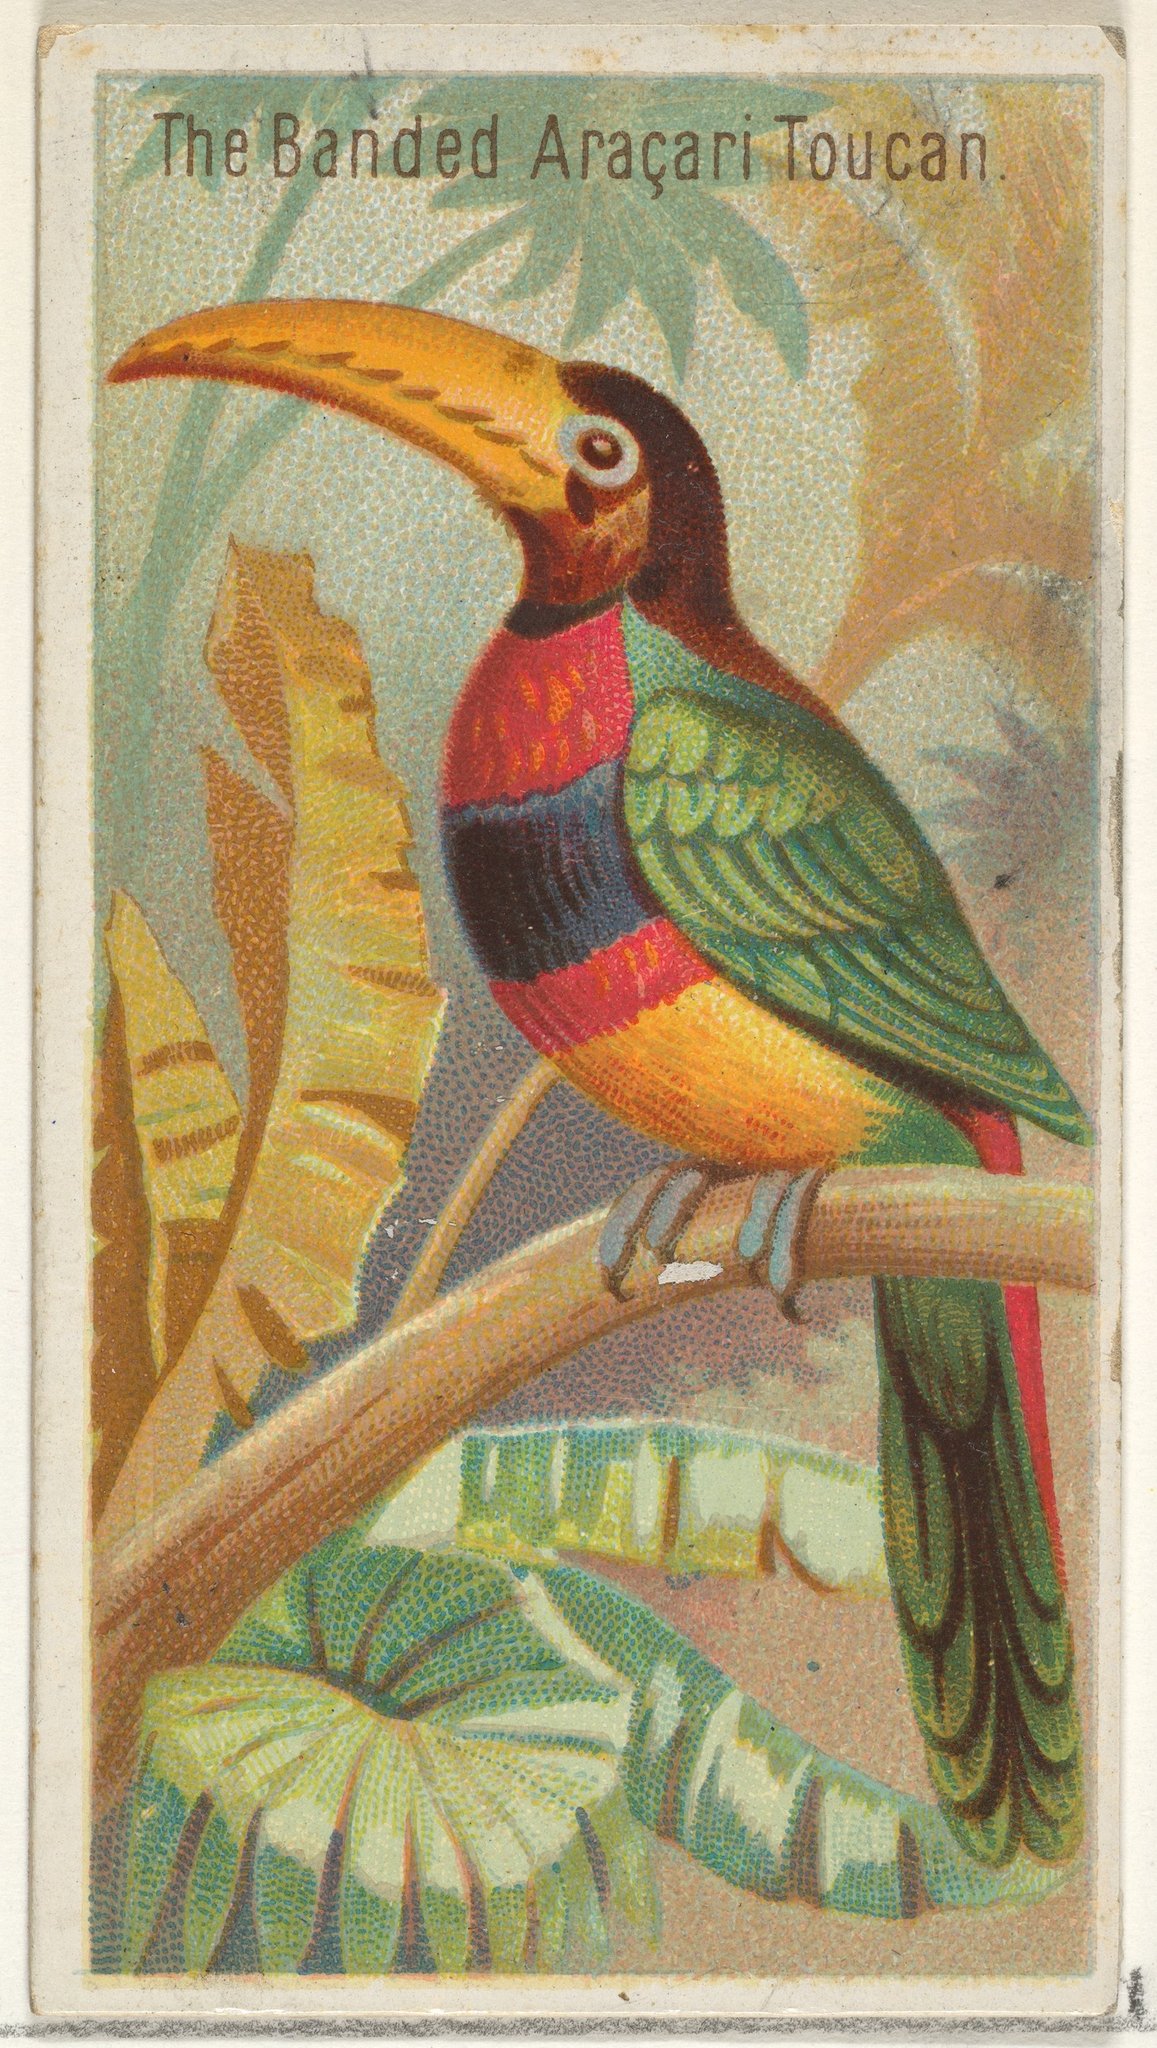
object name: print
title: The Banded Aracari Toucan, from the Birds of the Tropics series (N5) for Allen & Ginter Cigarettes Brands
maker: allen & ginter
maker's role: publisher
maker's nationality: american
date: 1889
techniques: color lithograph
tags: birds